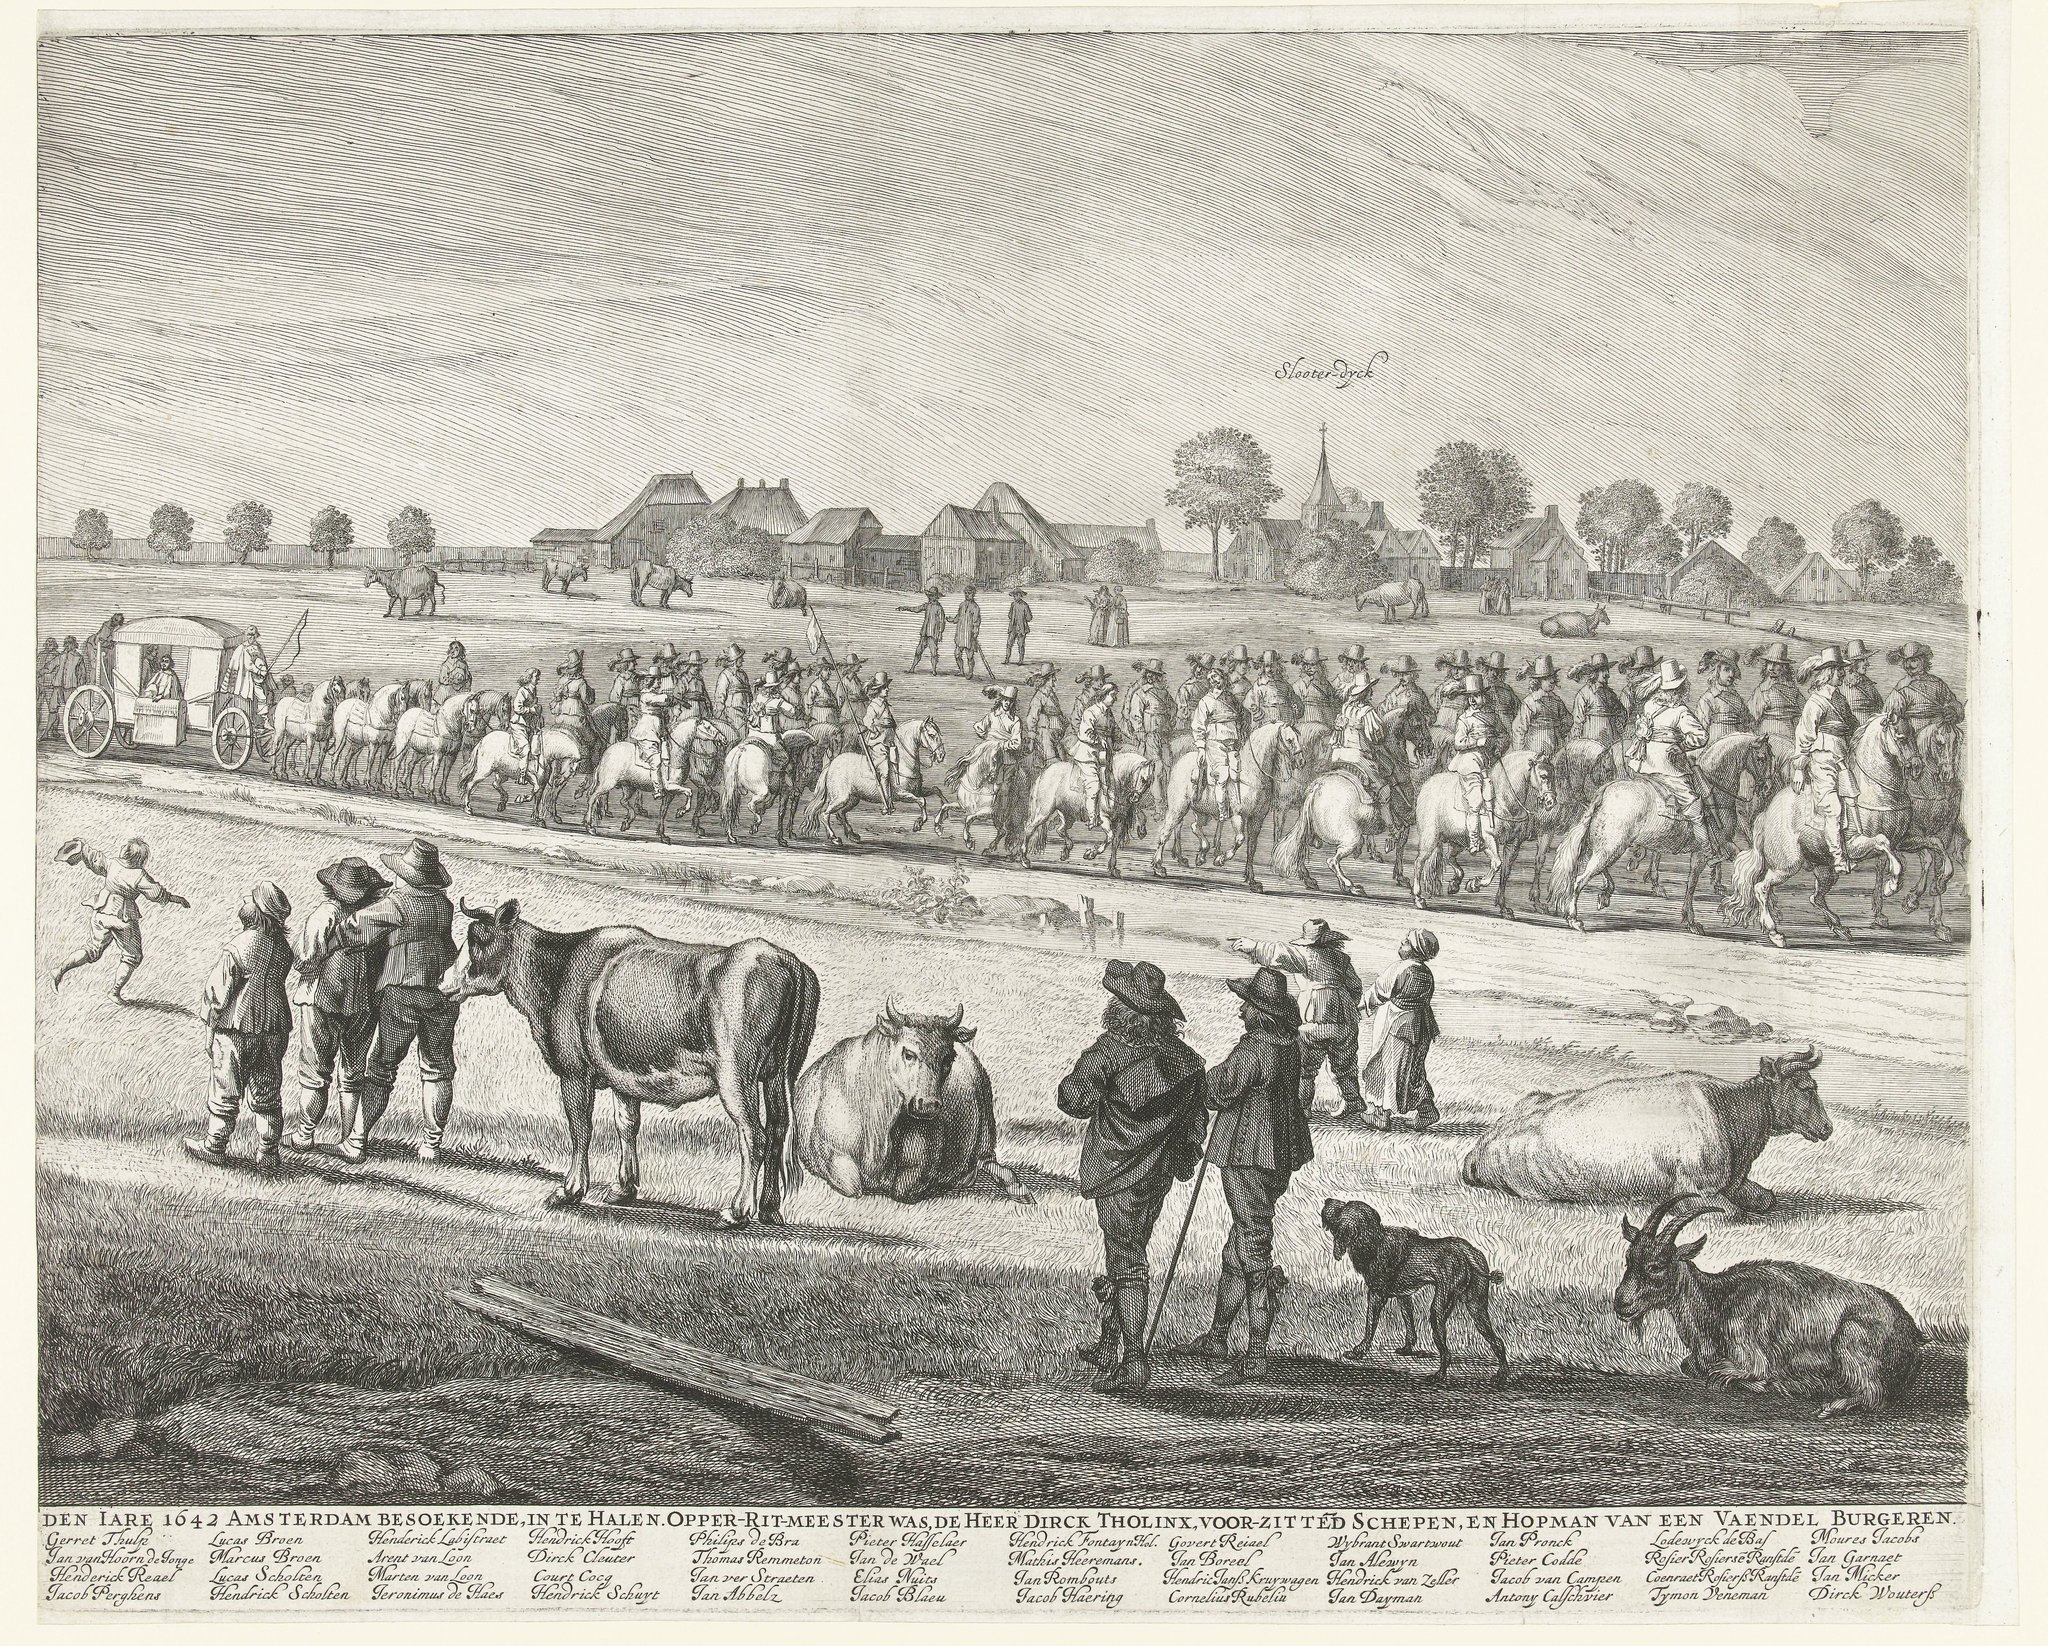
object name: print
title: Optocht van de schutters langs de Haarlemmertrekvaart bij de intocht van koningin Henrietta Maria te Amsterdam, 1642 (middenblad)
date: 1642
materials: paper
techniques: etching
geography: northern netherlands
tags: henriëtta maria van frankrijk (koningin van engeland, schotland en ierland), triumphal entry and public reception, pageant, 'entrée solennelle', 'joyeuse entrée', sloterdijk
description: Optocht van de schutters langs de Haarlemmertrekvaart bij de intocht van Engelse koningin Henrietta Maria te Amsterdam, 20 mei 1642. Geheel bestaande uit drie bladen: middenblad. De stoet met een rijtuig begeleid door ruiters trekt langs Sloterdijk. Op de voorgrond toeschouwers en vee. In het onderschrift een lijst in 12 kolommen met een deel van de namen van de ruiters in de stoet.